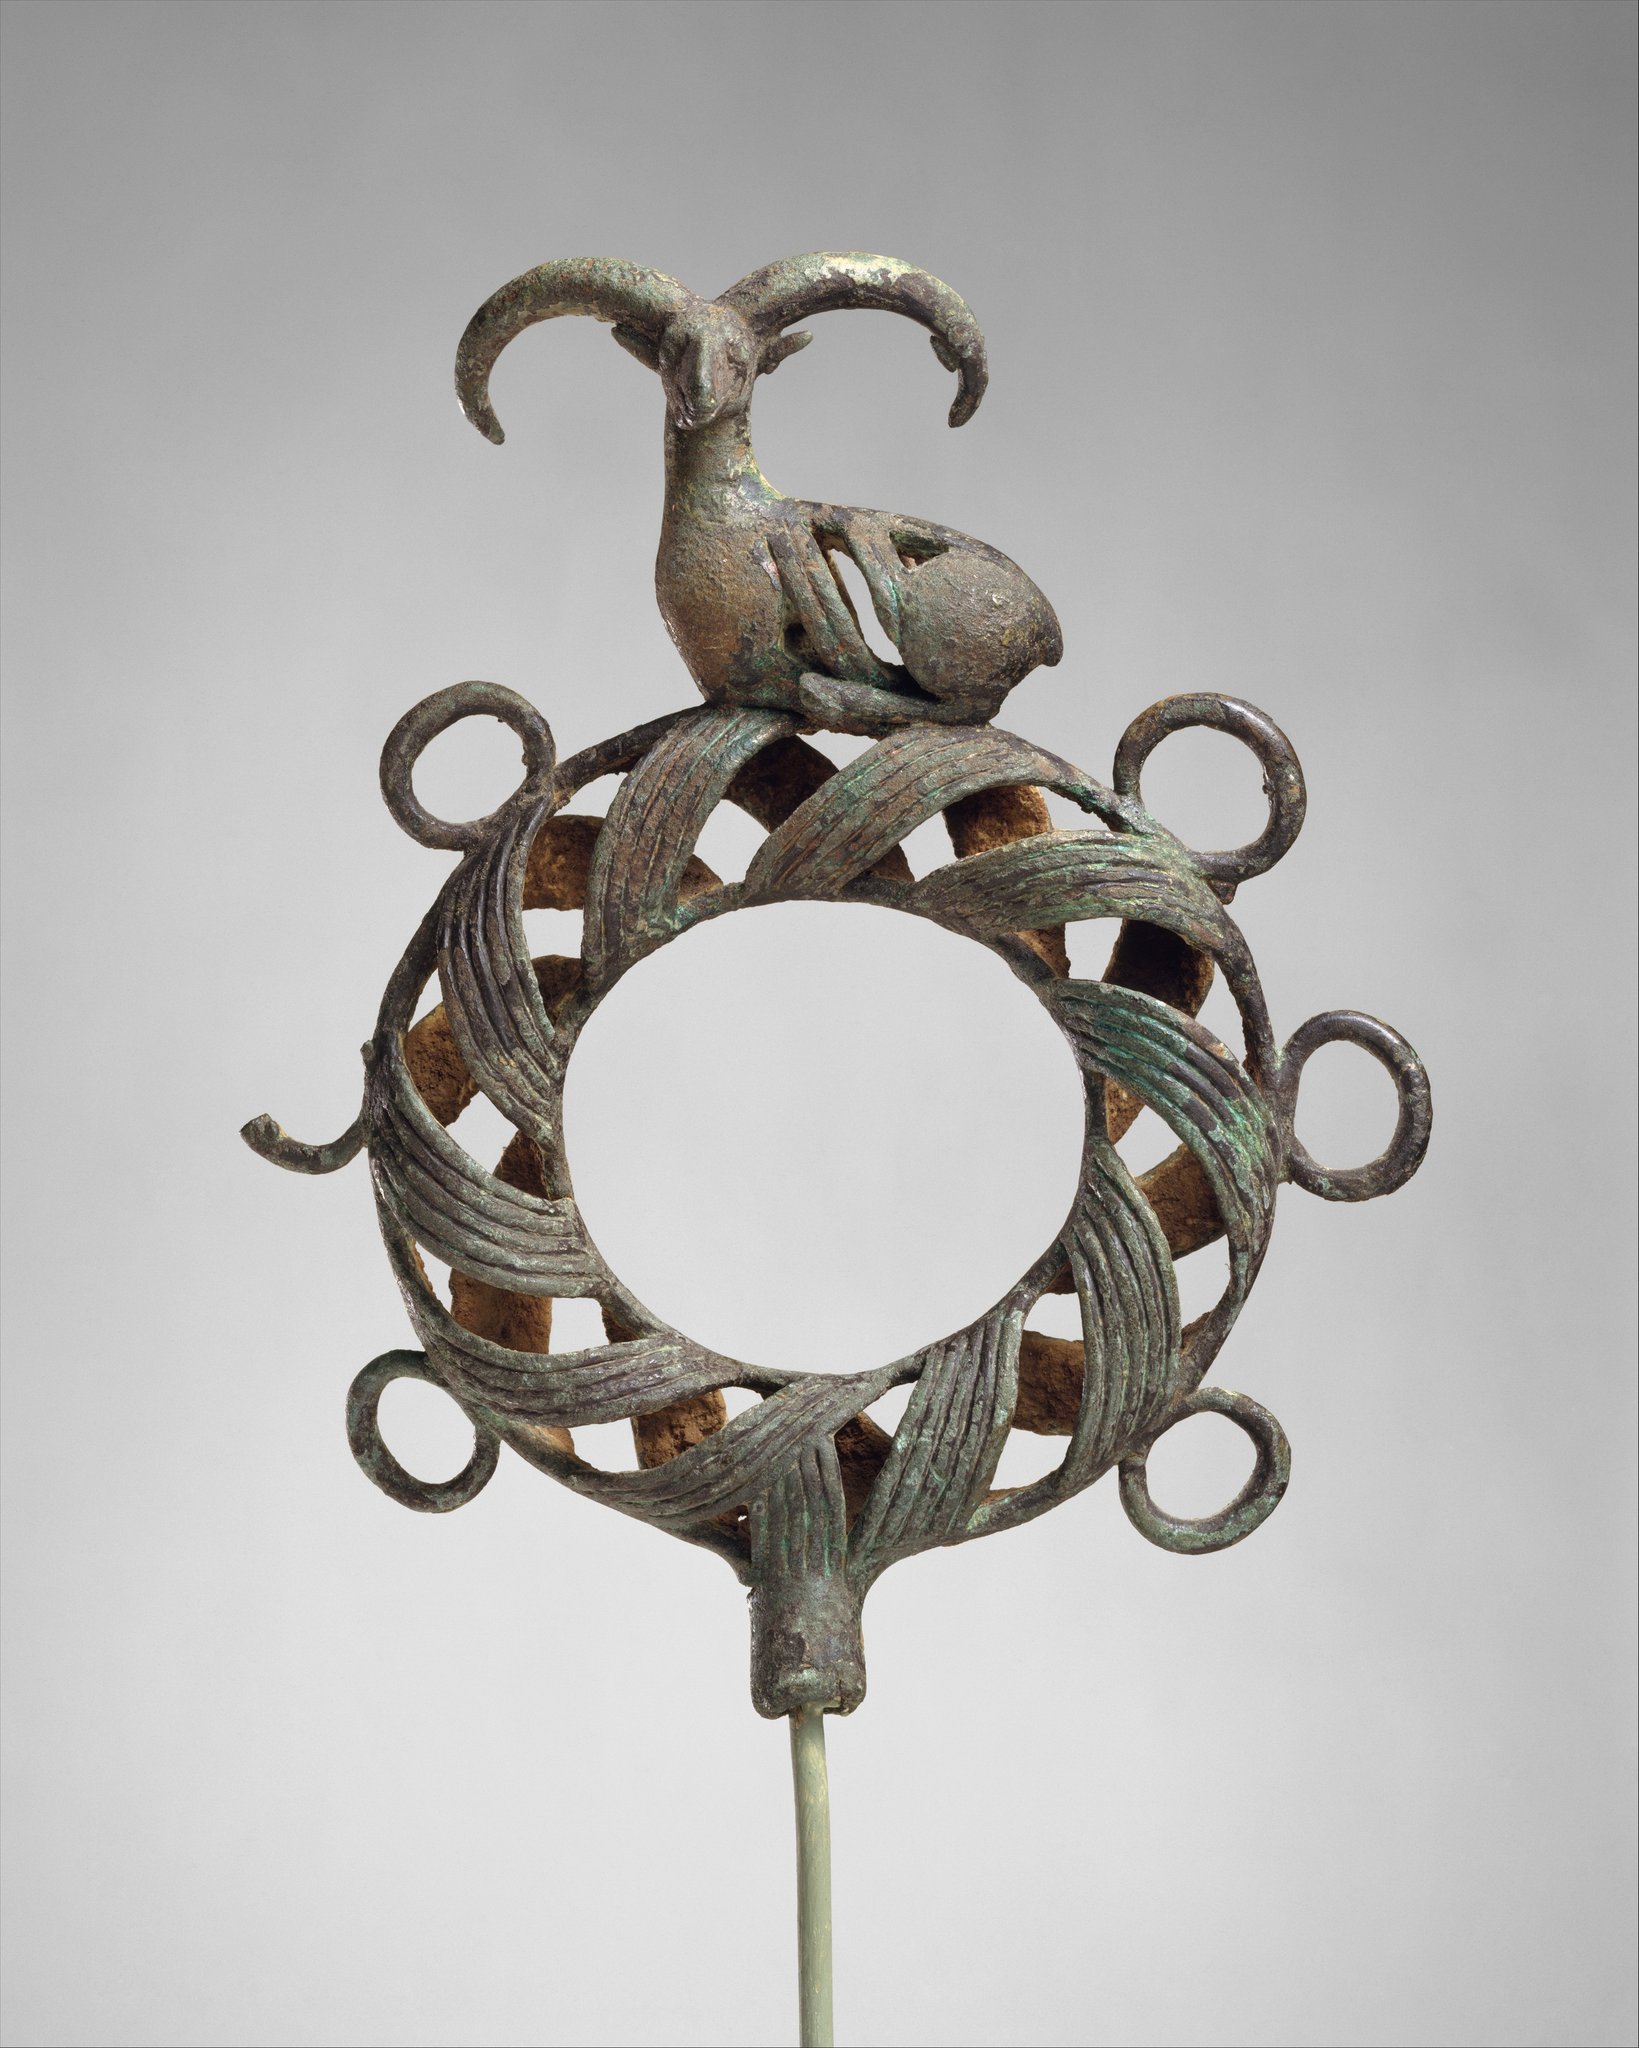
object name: standard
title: Standard surmounted by a ram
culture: iranian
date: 1333-1001 BCE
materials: bronze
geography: iran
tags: rams